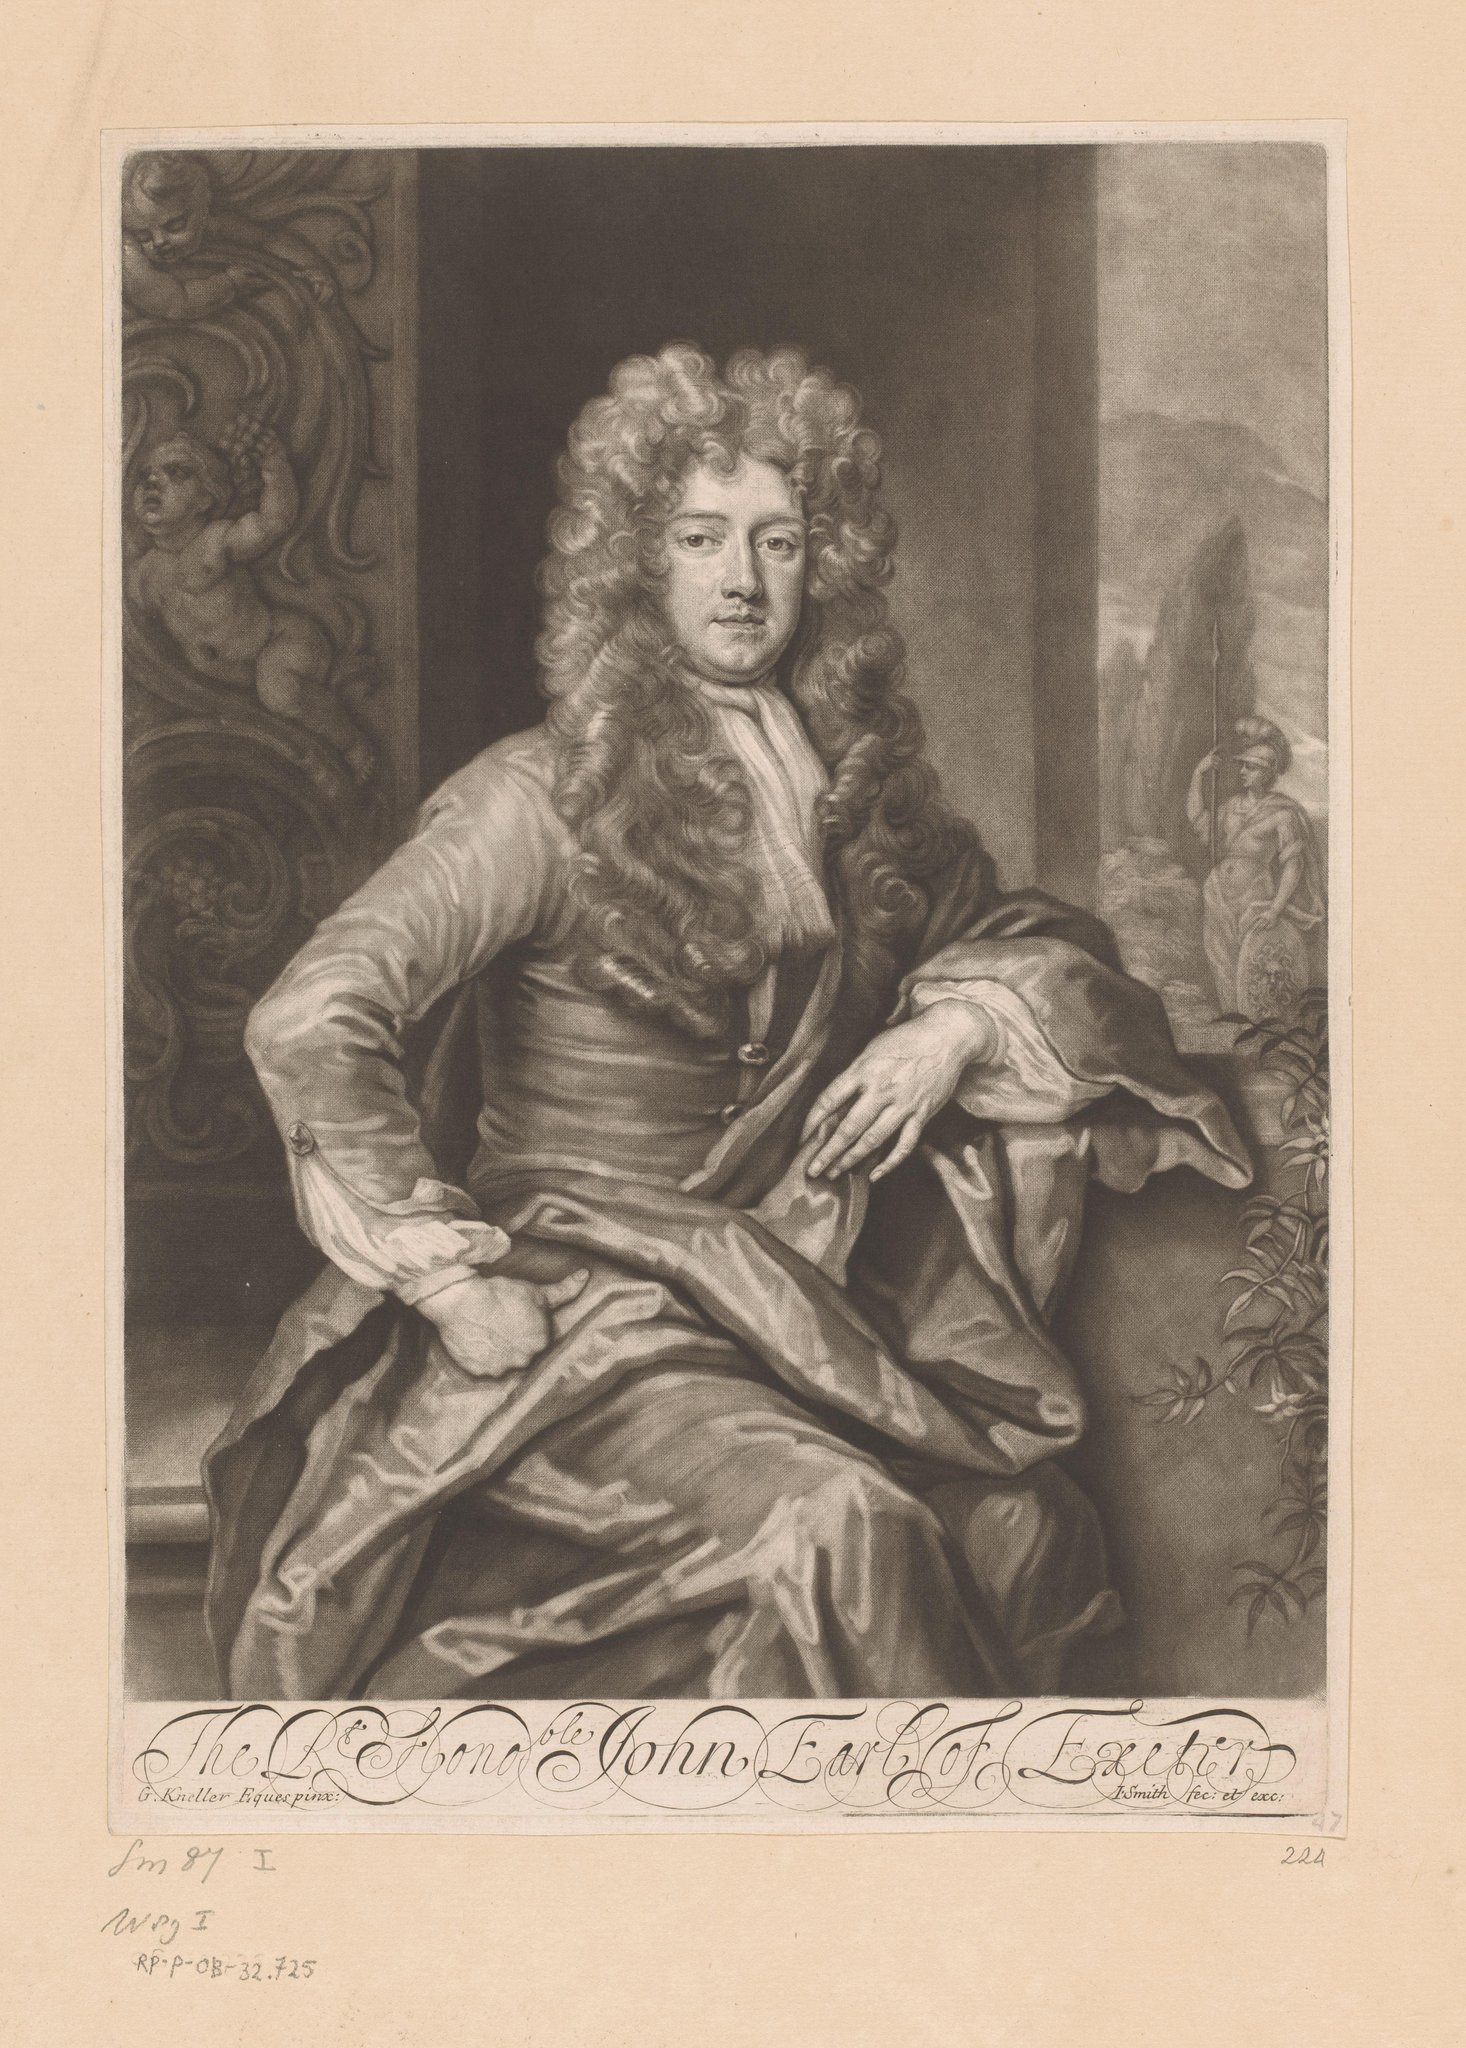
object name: print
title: The Right Honorable John Earl of Exeter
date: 1662-1742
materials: paper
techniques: mezzotint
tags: historical persons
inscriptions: collector's mark: Lugt 240